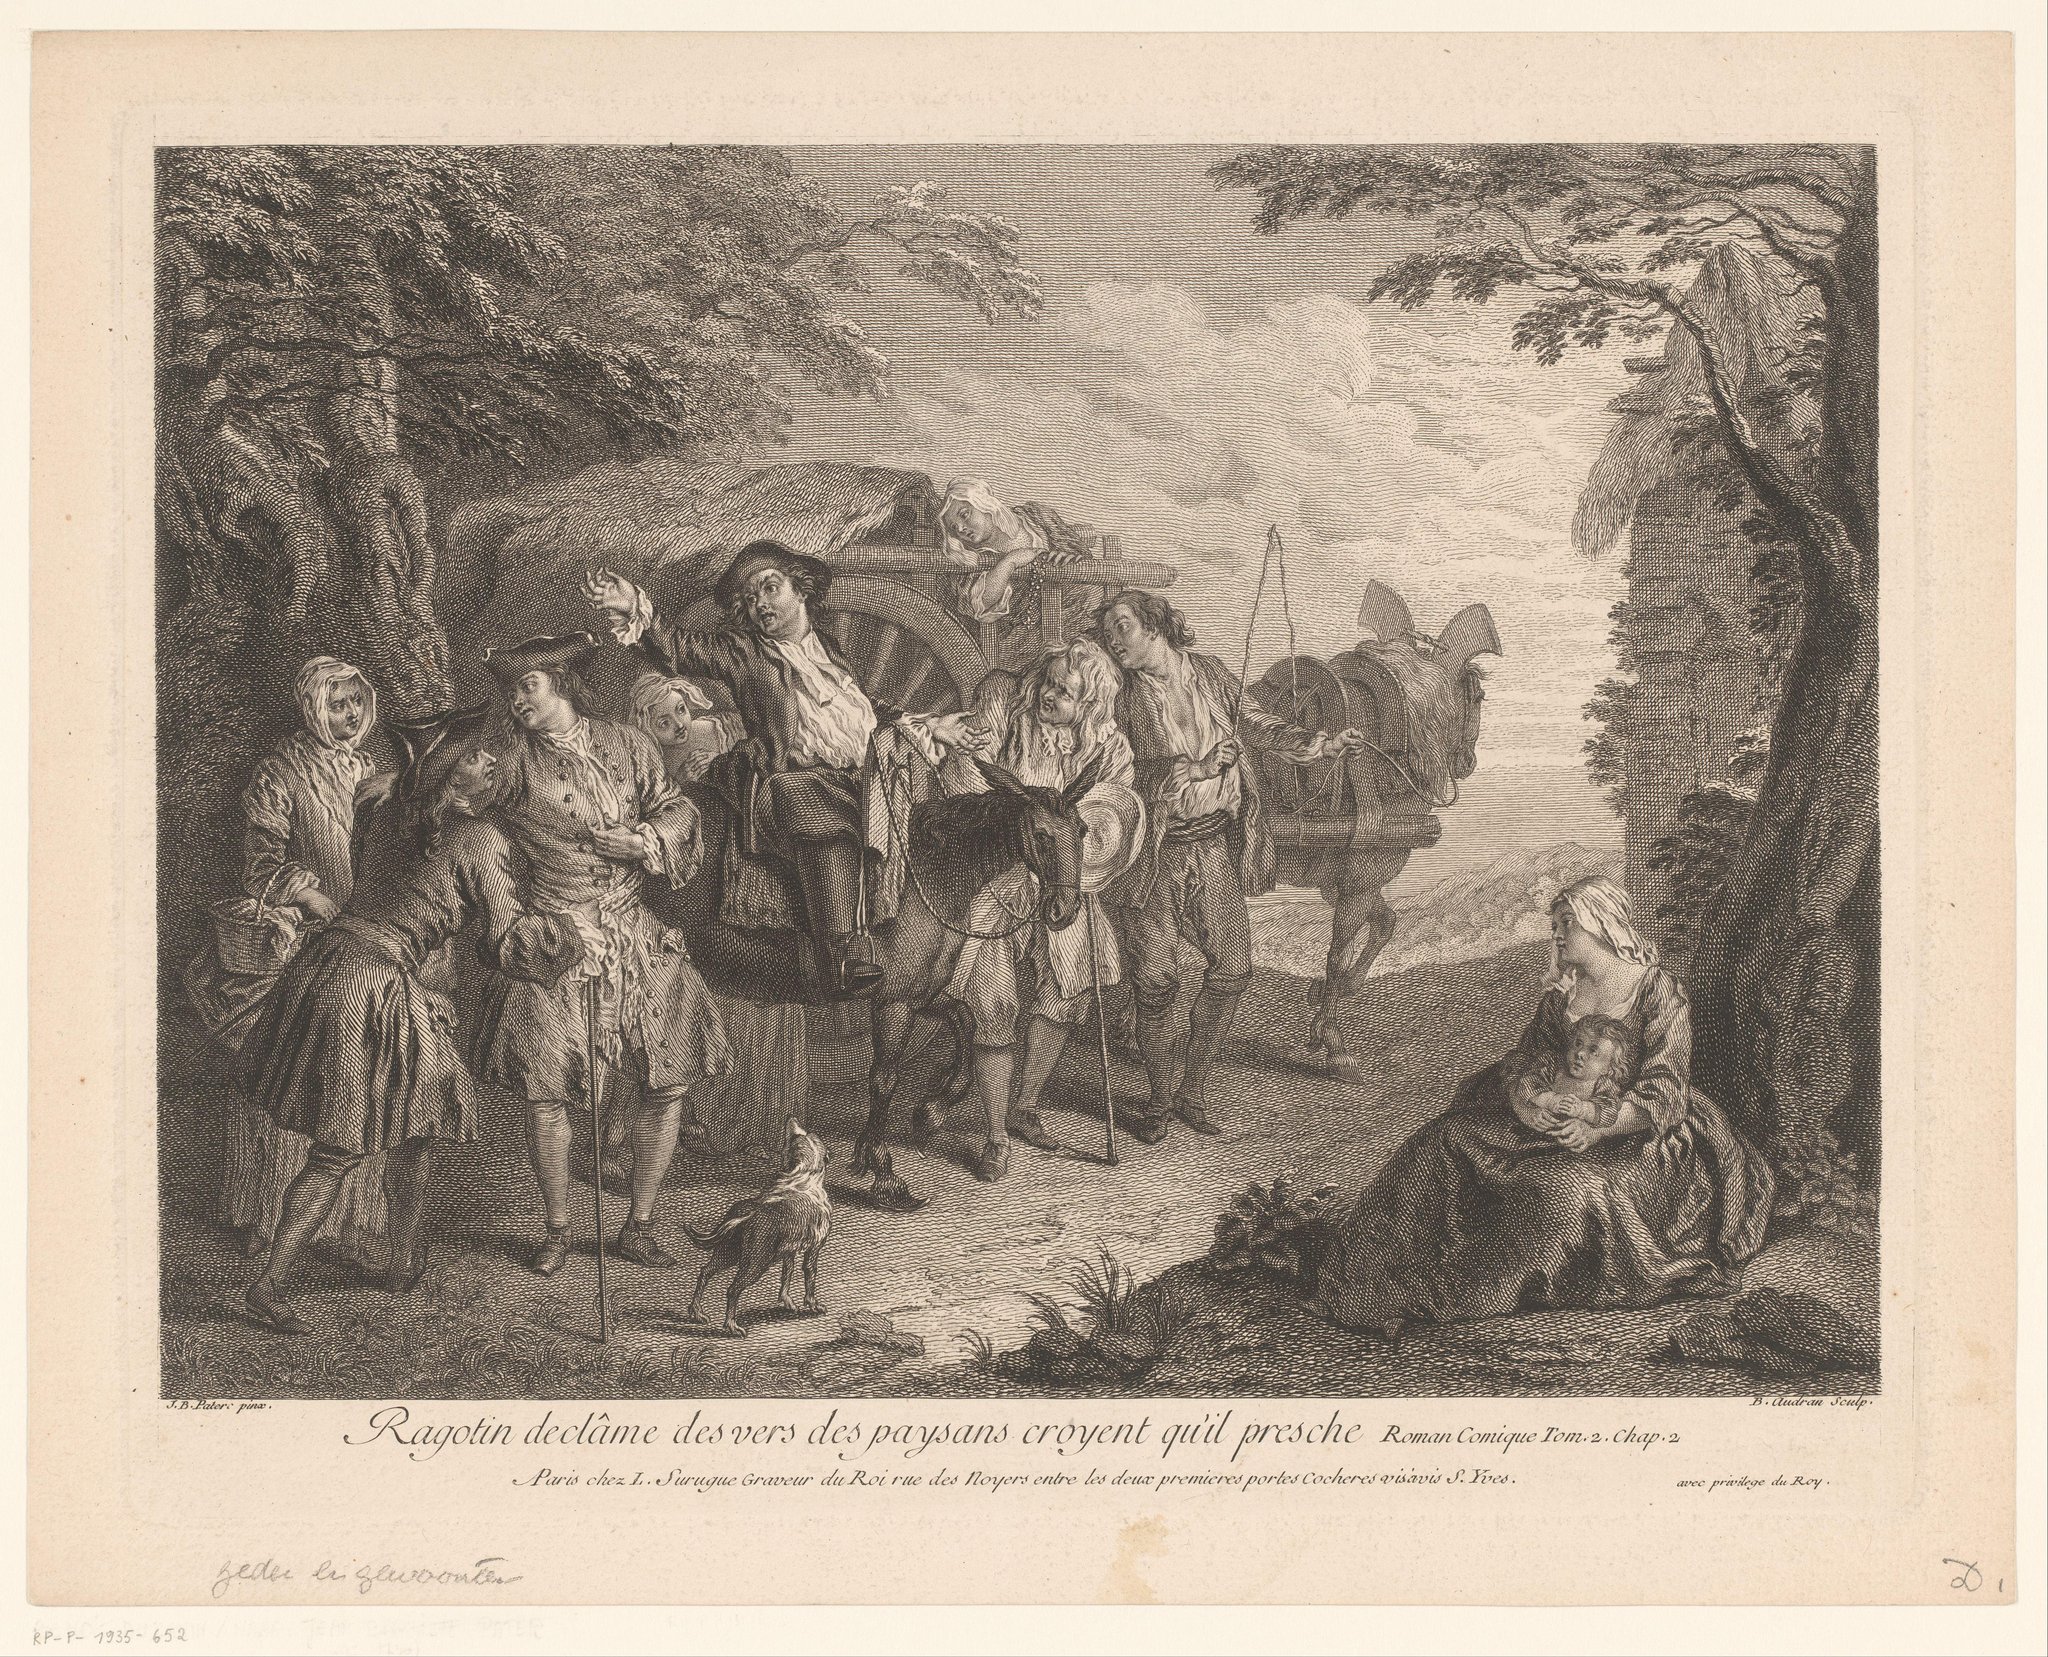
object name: print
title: Ragotin declâme des vers des paysans croyent qu'il presche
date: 1708-1762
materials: paper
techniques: etching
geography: paris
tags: troupe (actors) 'en route', (scarron, roman comique) specific works of literature (with author, title)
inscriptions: collector's mark: Lugt 2228